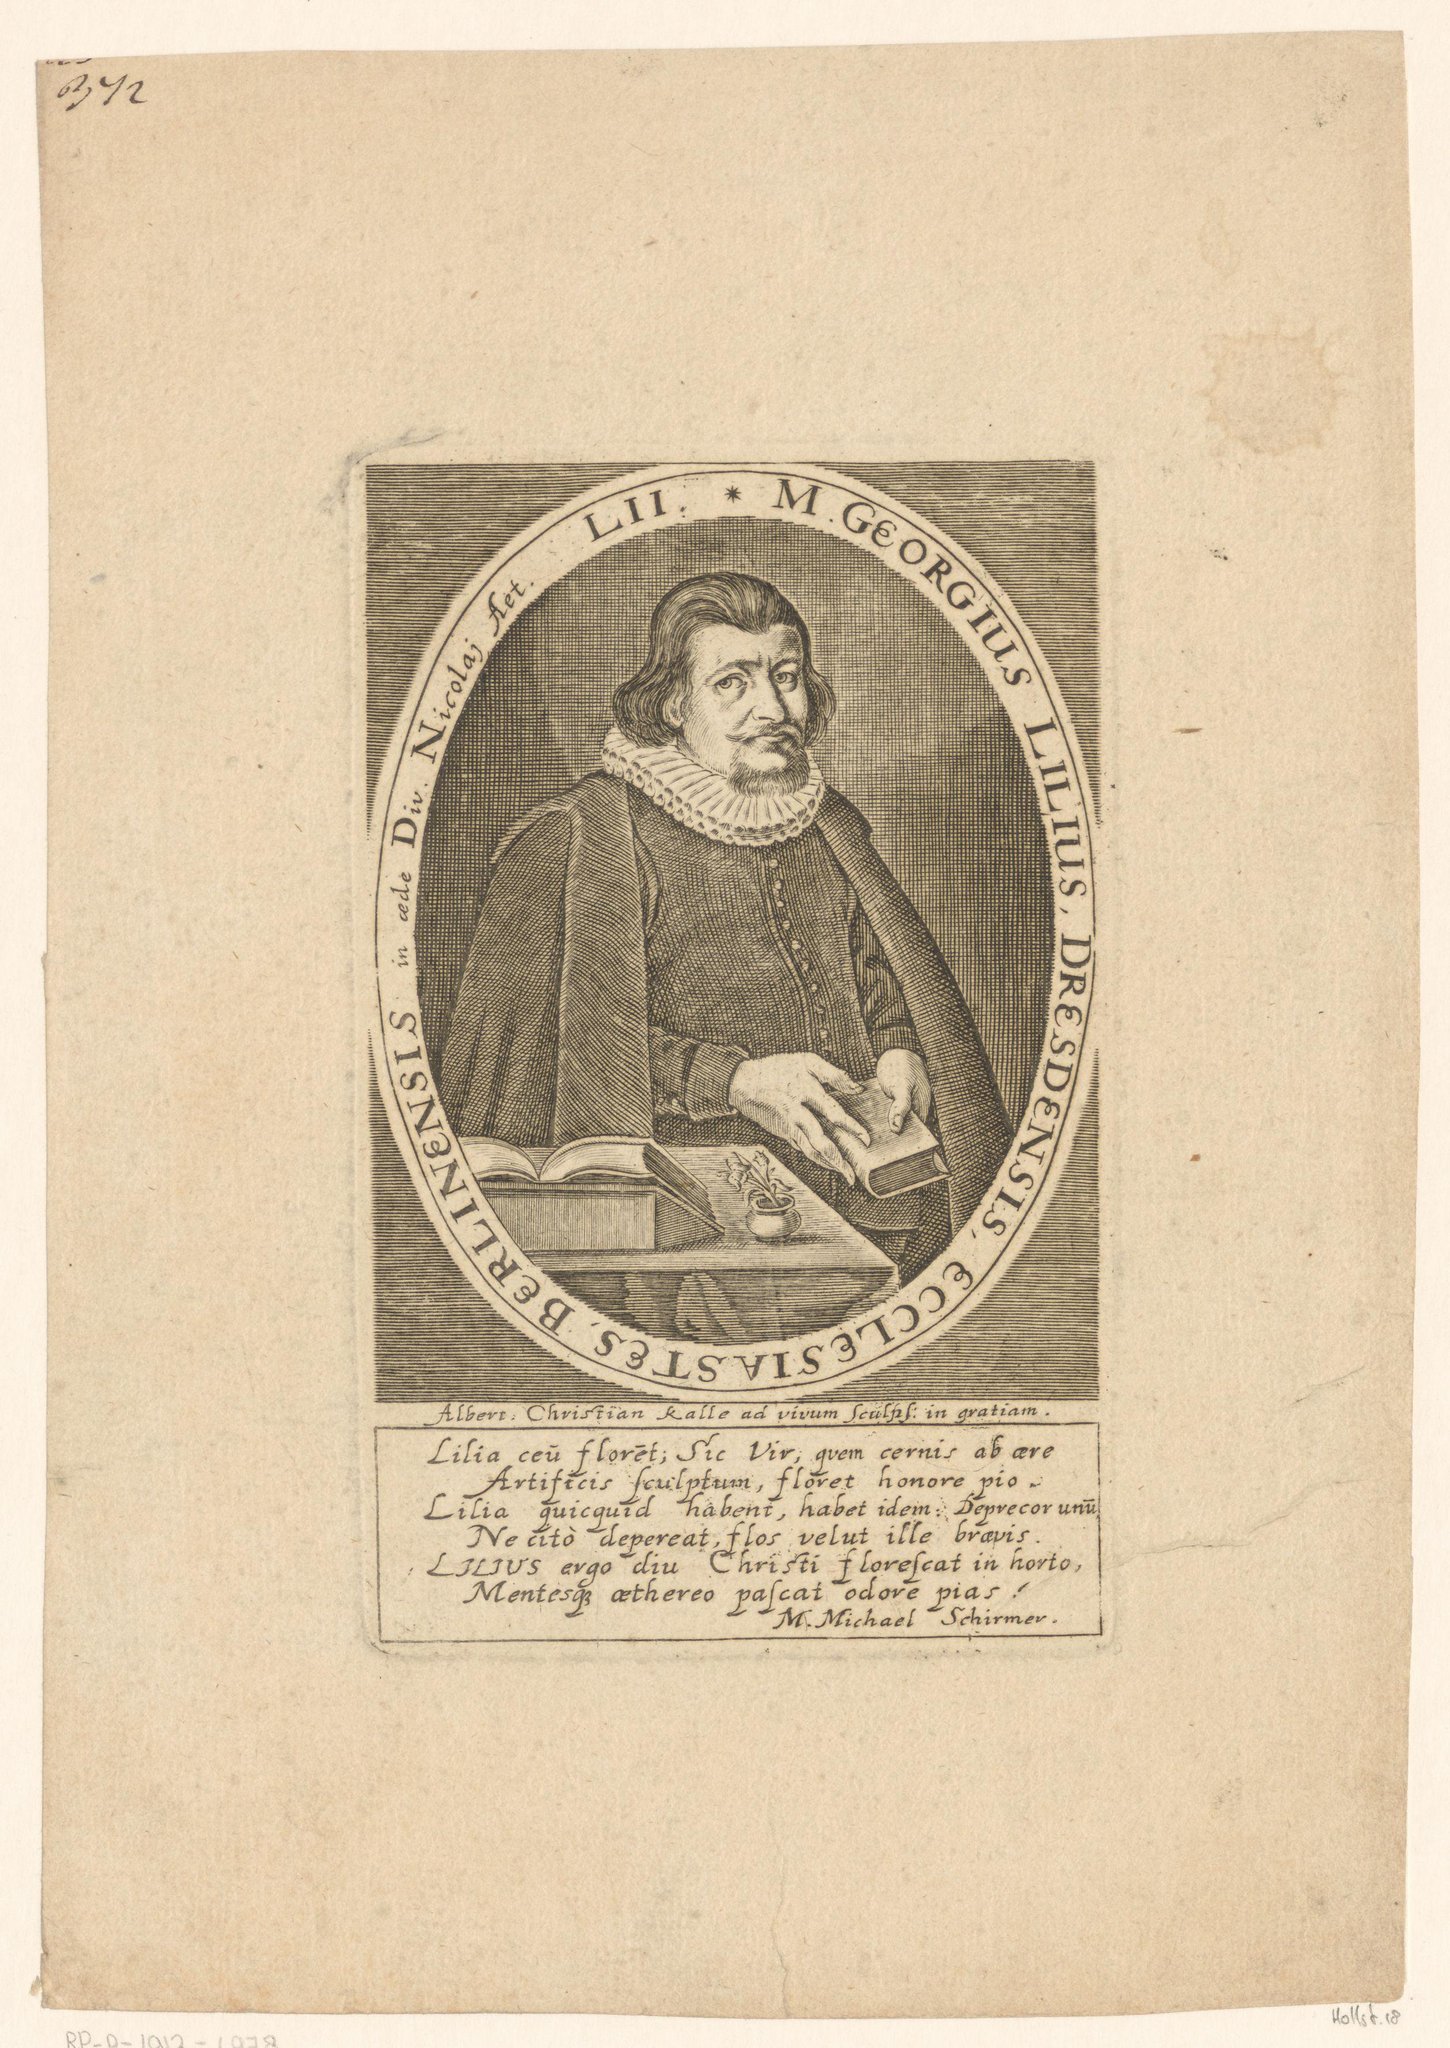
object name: print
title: Portret van Georg Lilien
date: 1666-1670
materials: paper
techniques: engraving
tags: priest, theologian, historical persons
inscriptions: collector's mark: Lugt 2228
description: Tekst in het Latijn in de omlijsting en in de marge.